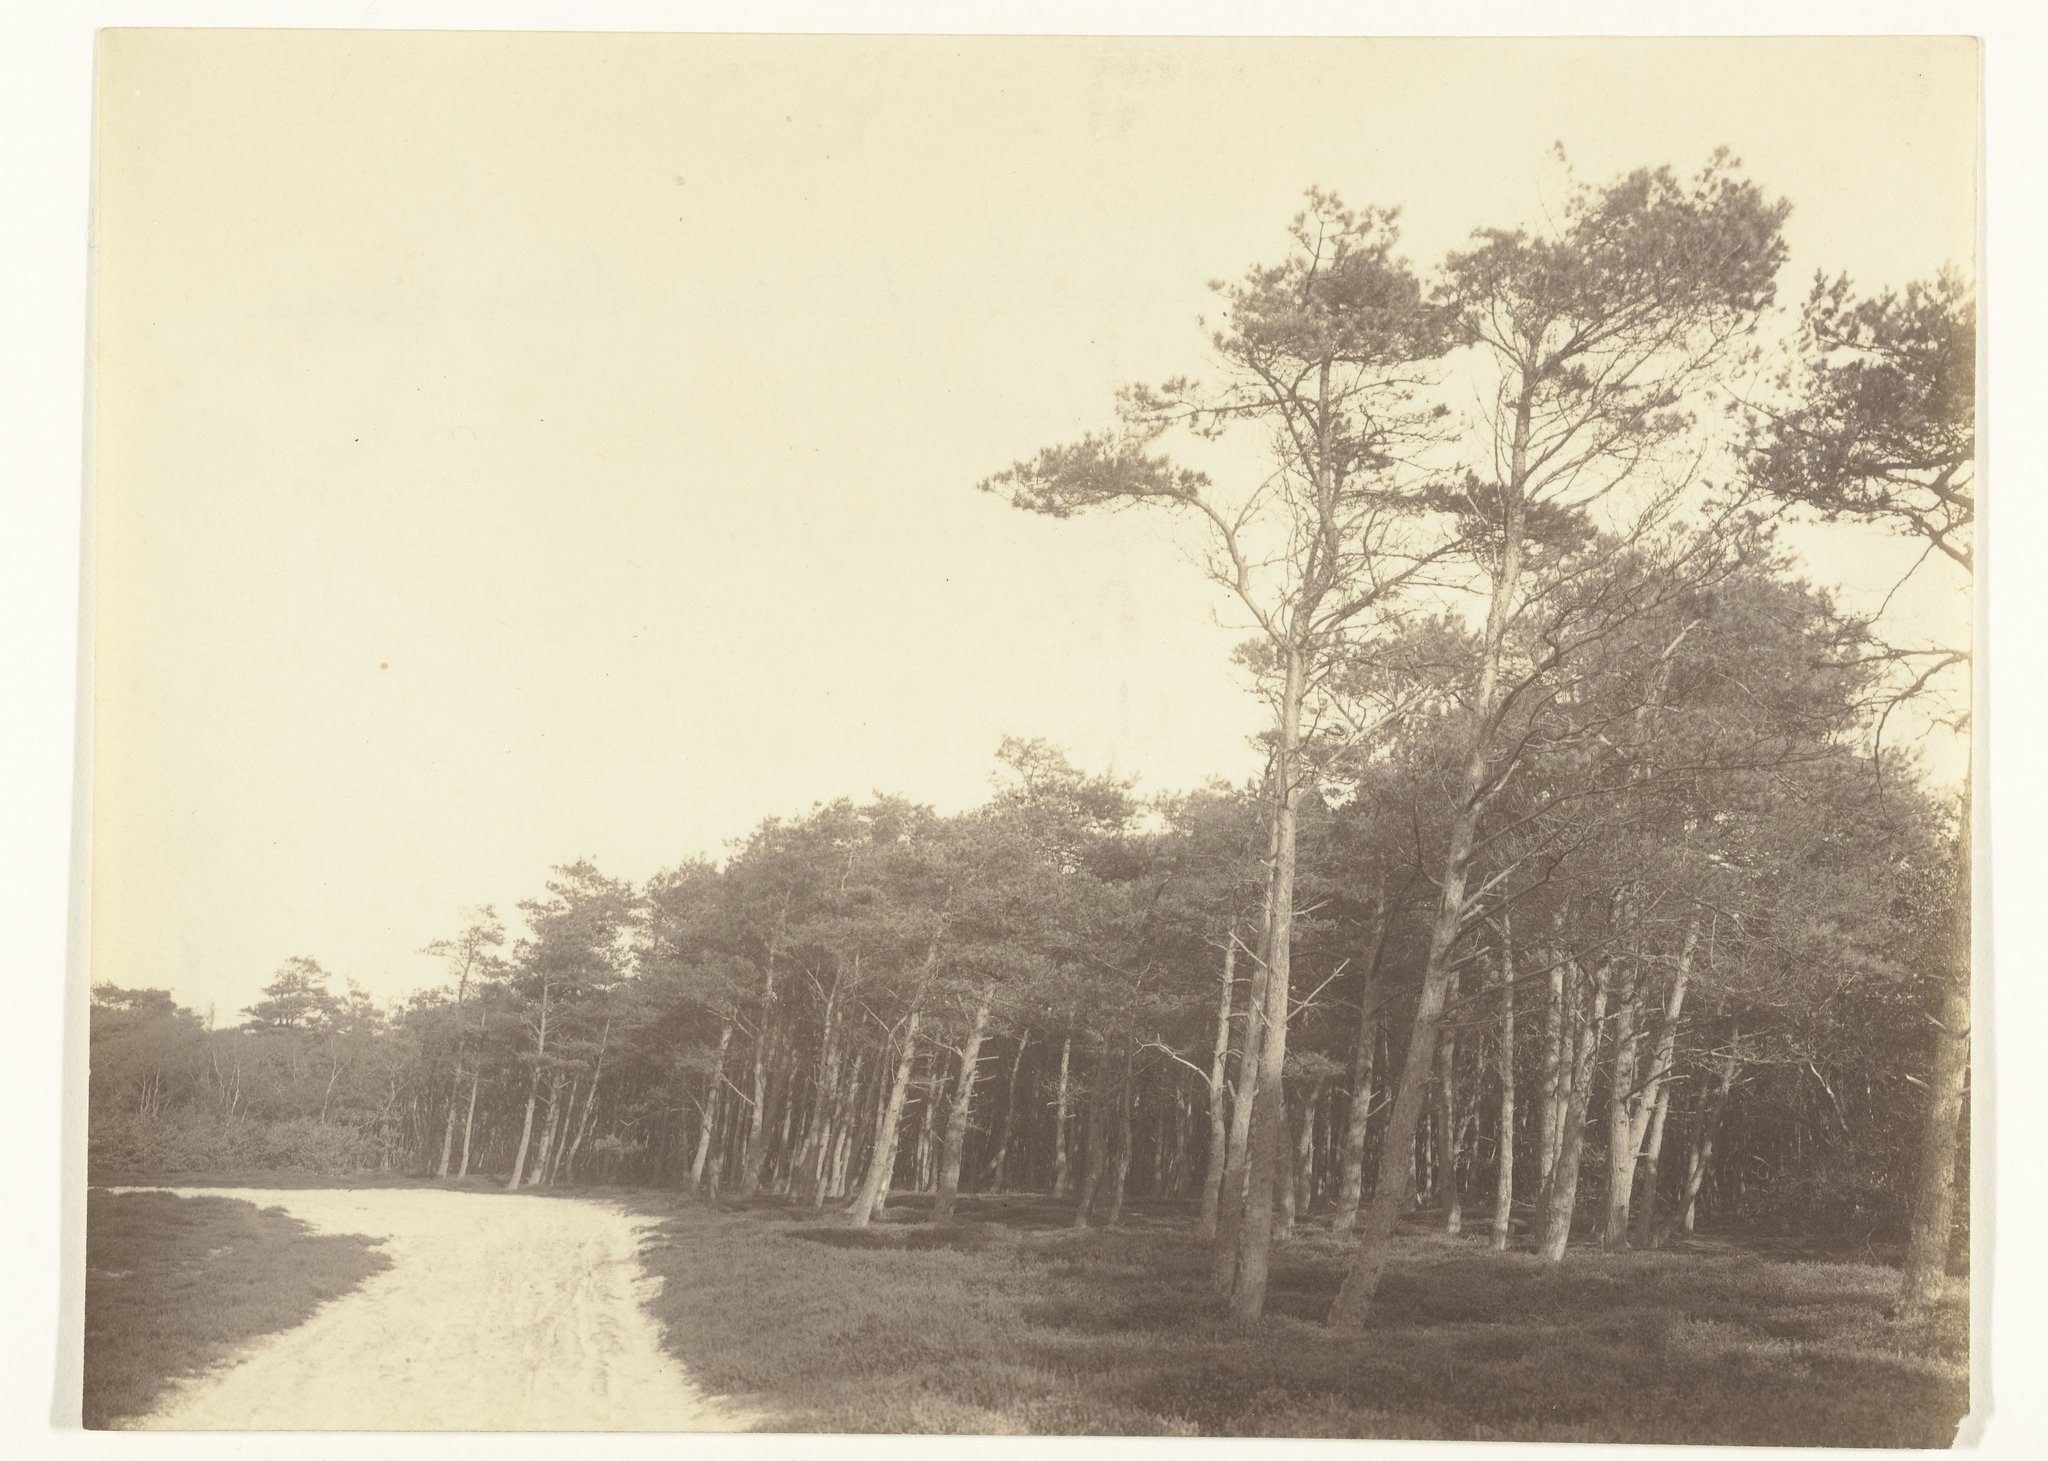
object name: photograph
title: Boekweitkroft en Dennen in de bosschen nabij Bergen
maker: richard tepe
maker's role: fotograaf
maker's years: 1864-1952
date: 1900-1930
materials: paper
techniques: albumen print, salted paper print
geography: netherlands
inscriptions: signature: ‘foto / R. Tepe’, annotation: ‘Boekweitkroft en Dennen / in de bosschen / nabij Bergen’